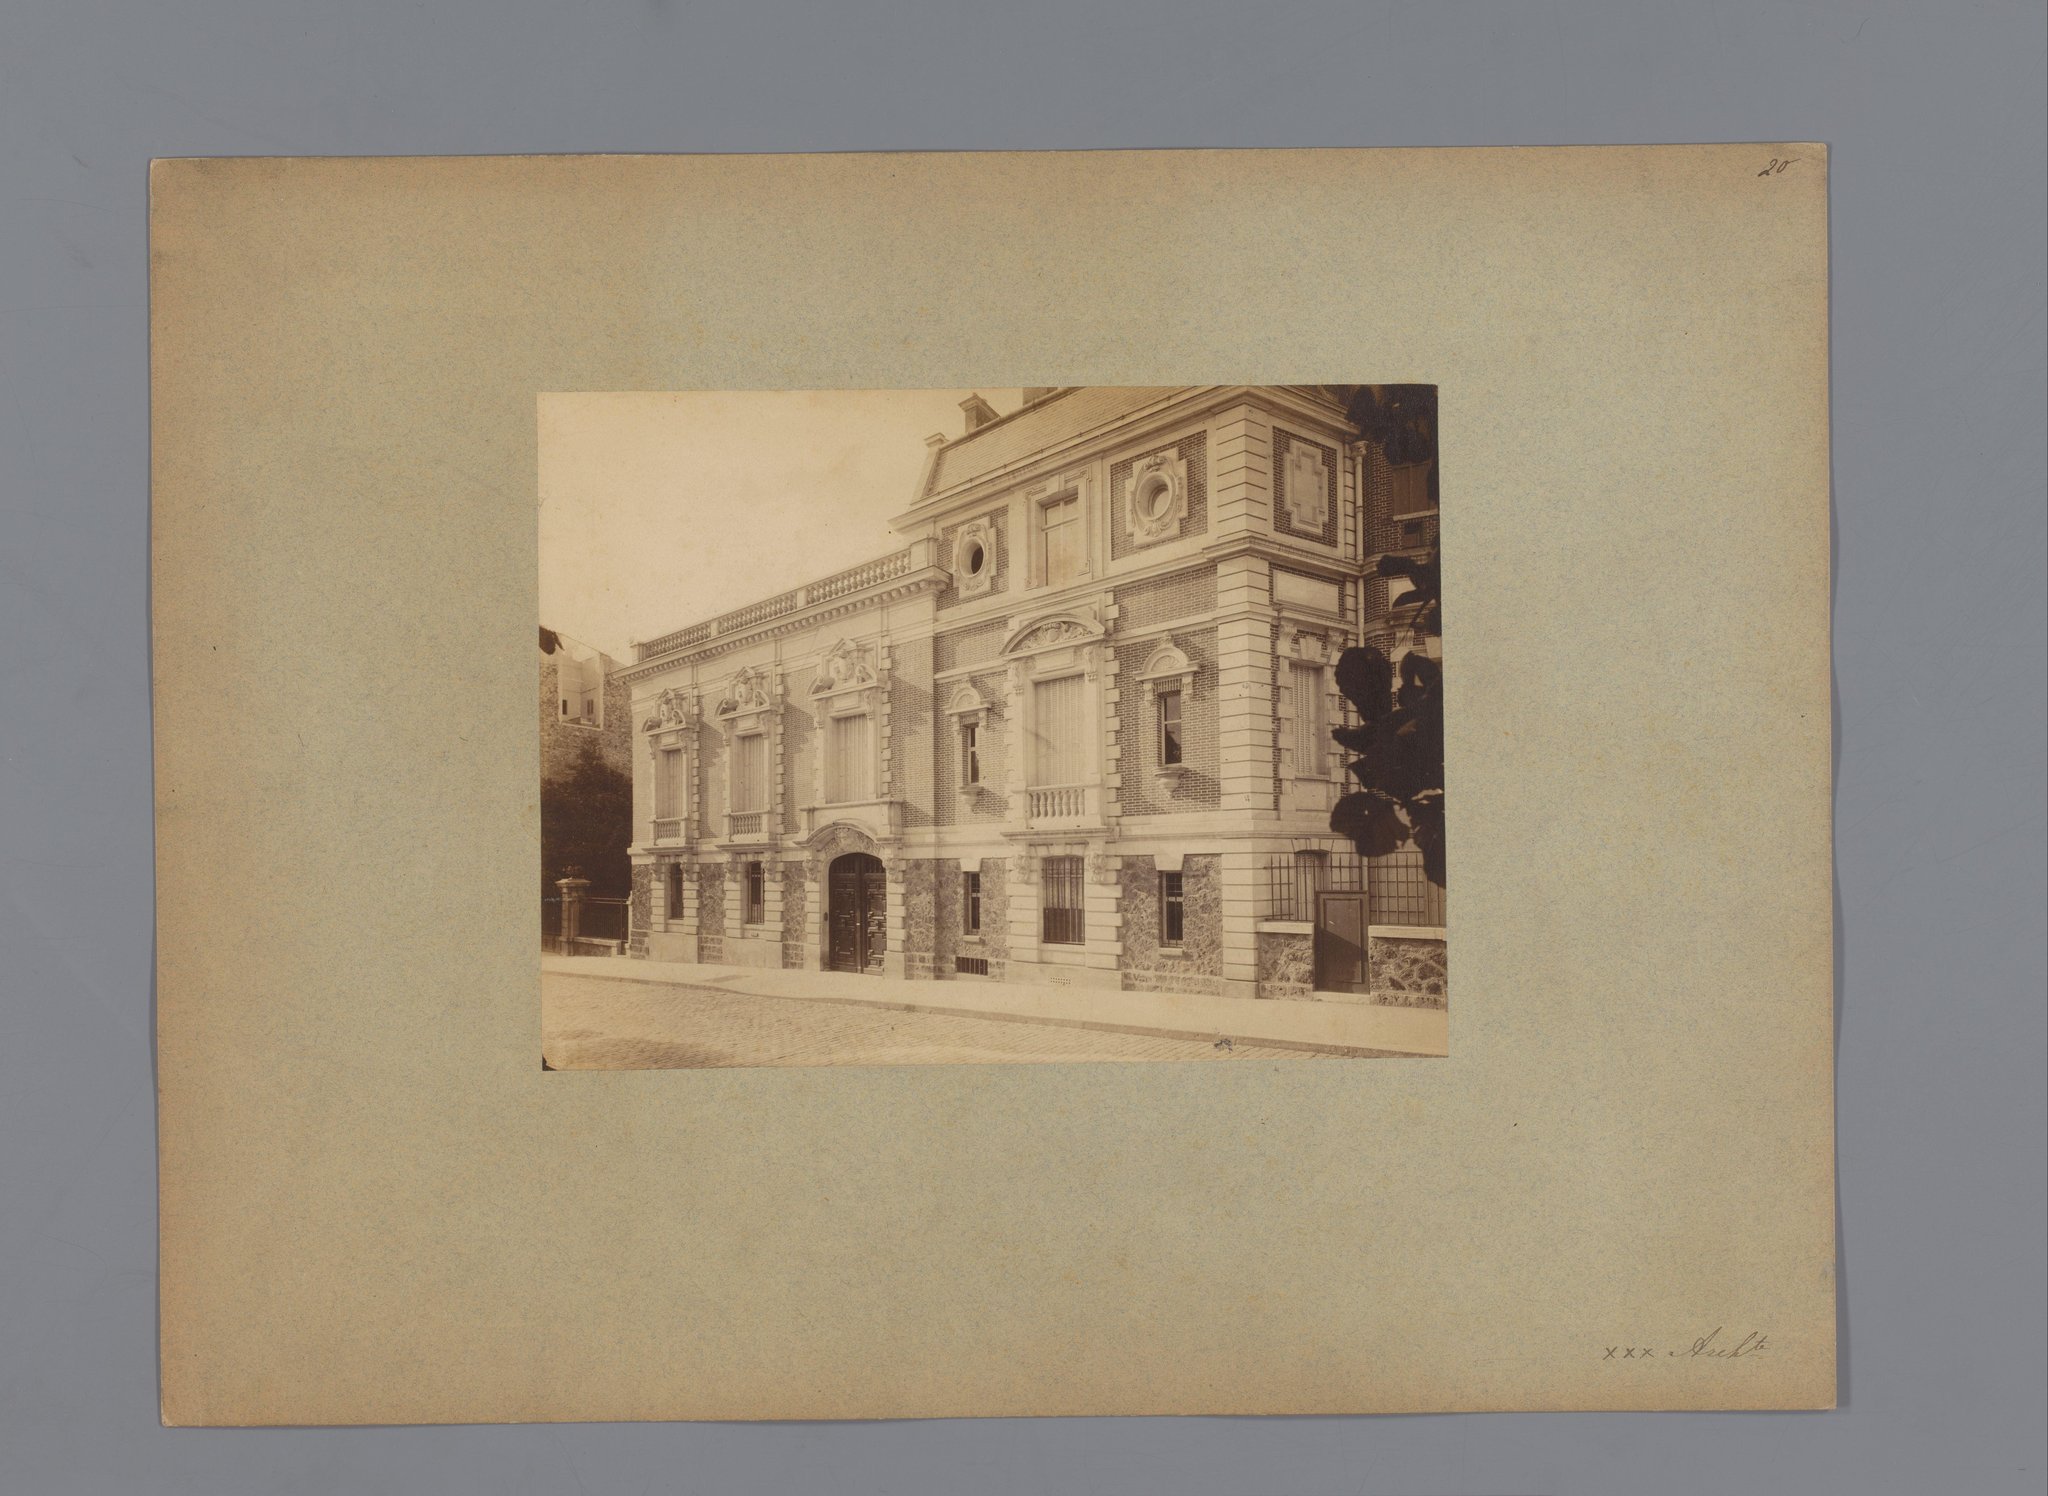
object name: photograph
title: Façade van een gebouw in Parijs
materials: photographic support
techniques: albumen print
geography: paris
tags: detached house in city, façade (of house or building), paris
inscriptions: name: ‘xxx Architecte’, number: ‘20’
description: Deze foto maakt deel uit van een omslag met 35 foto's en een titelblad.